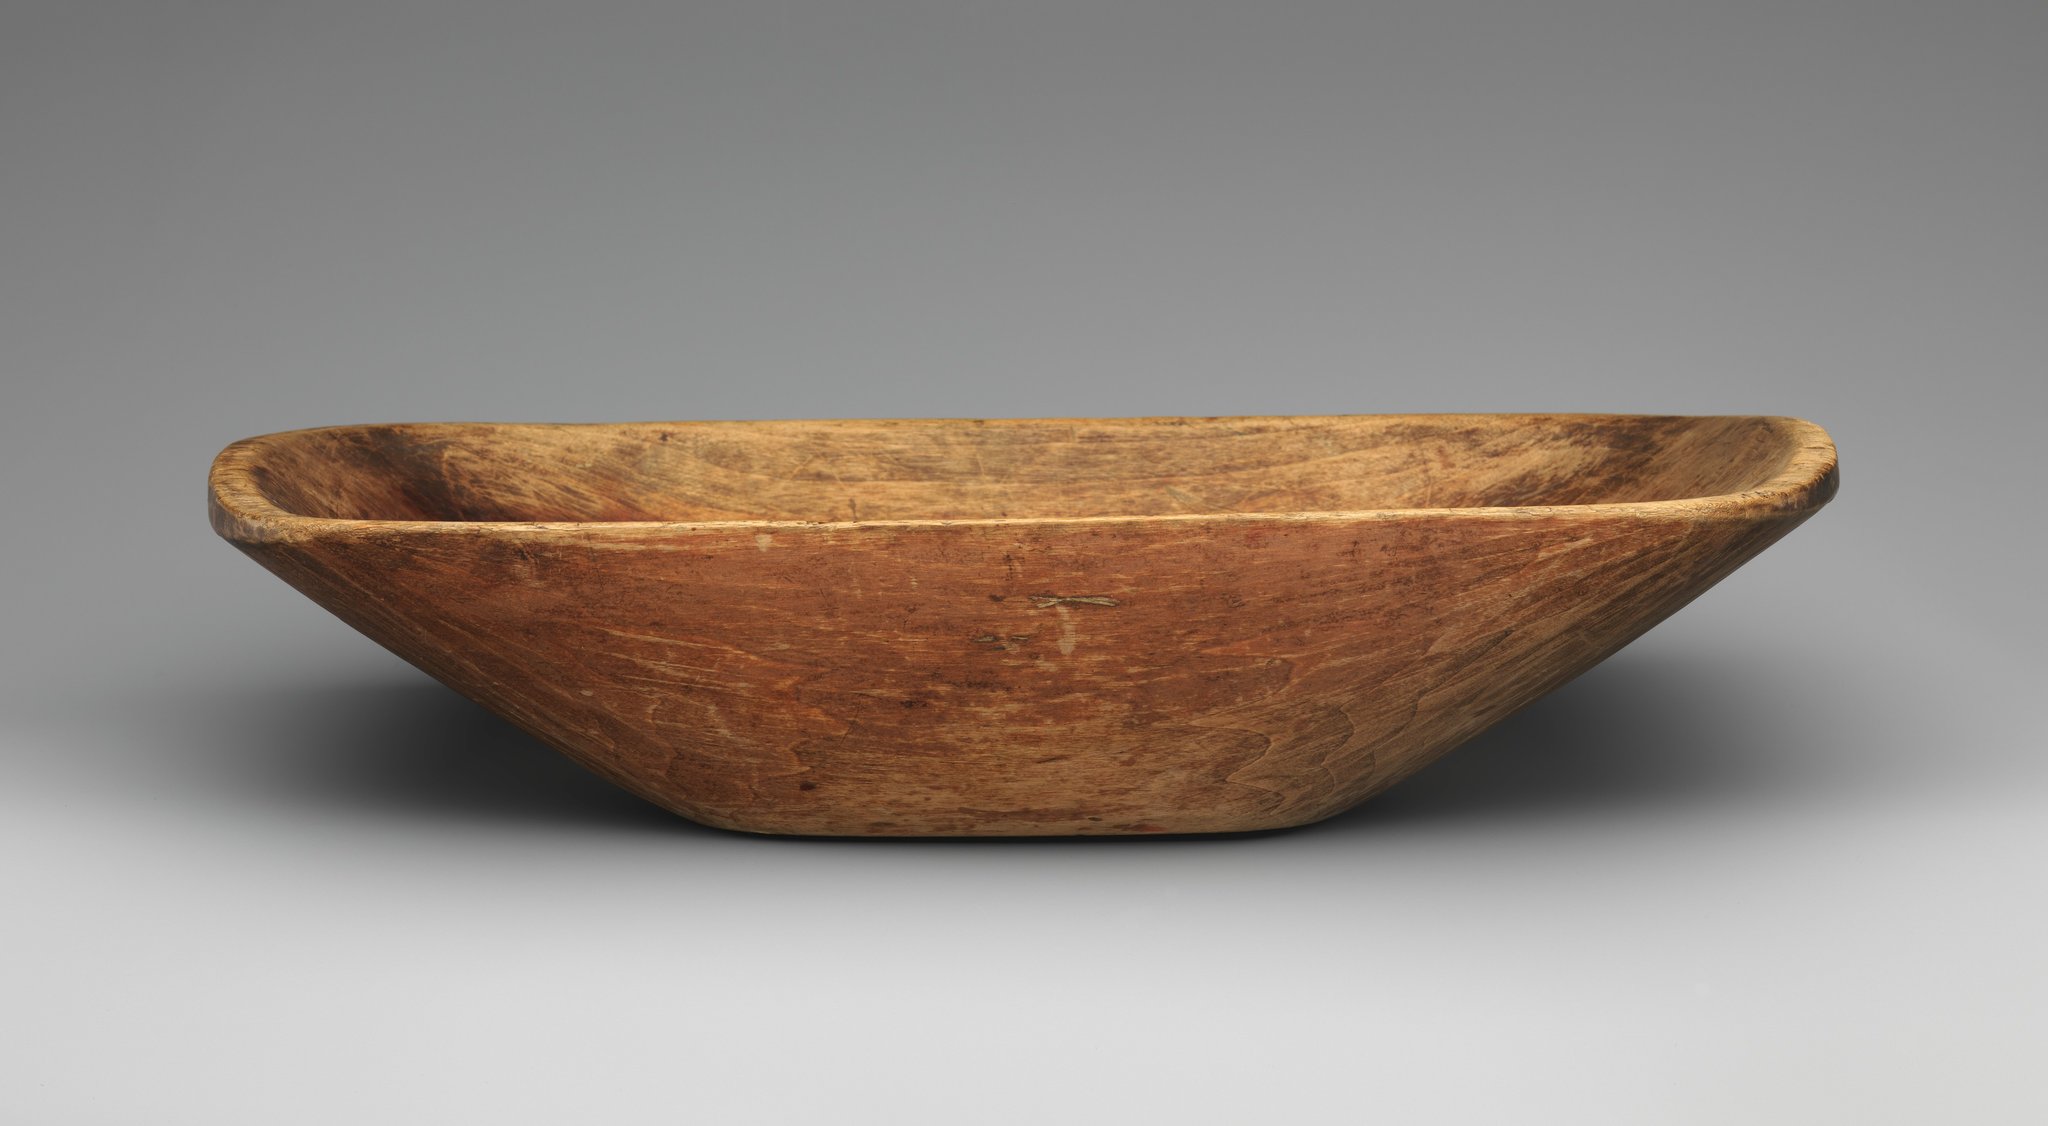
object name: bowl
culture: american, shaker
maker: isaac n. youngs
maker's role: maker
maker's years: 1793-1865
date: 1810-1865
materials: wood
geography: united states